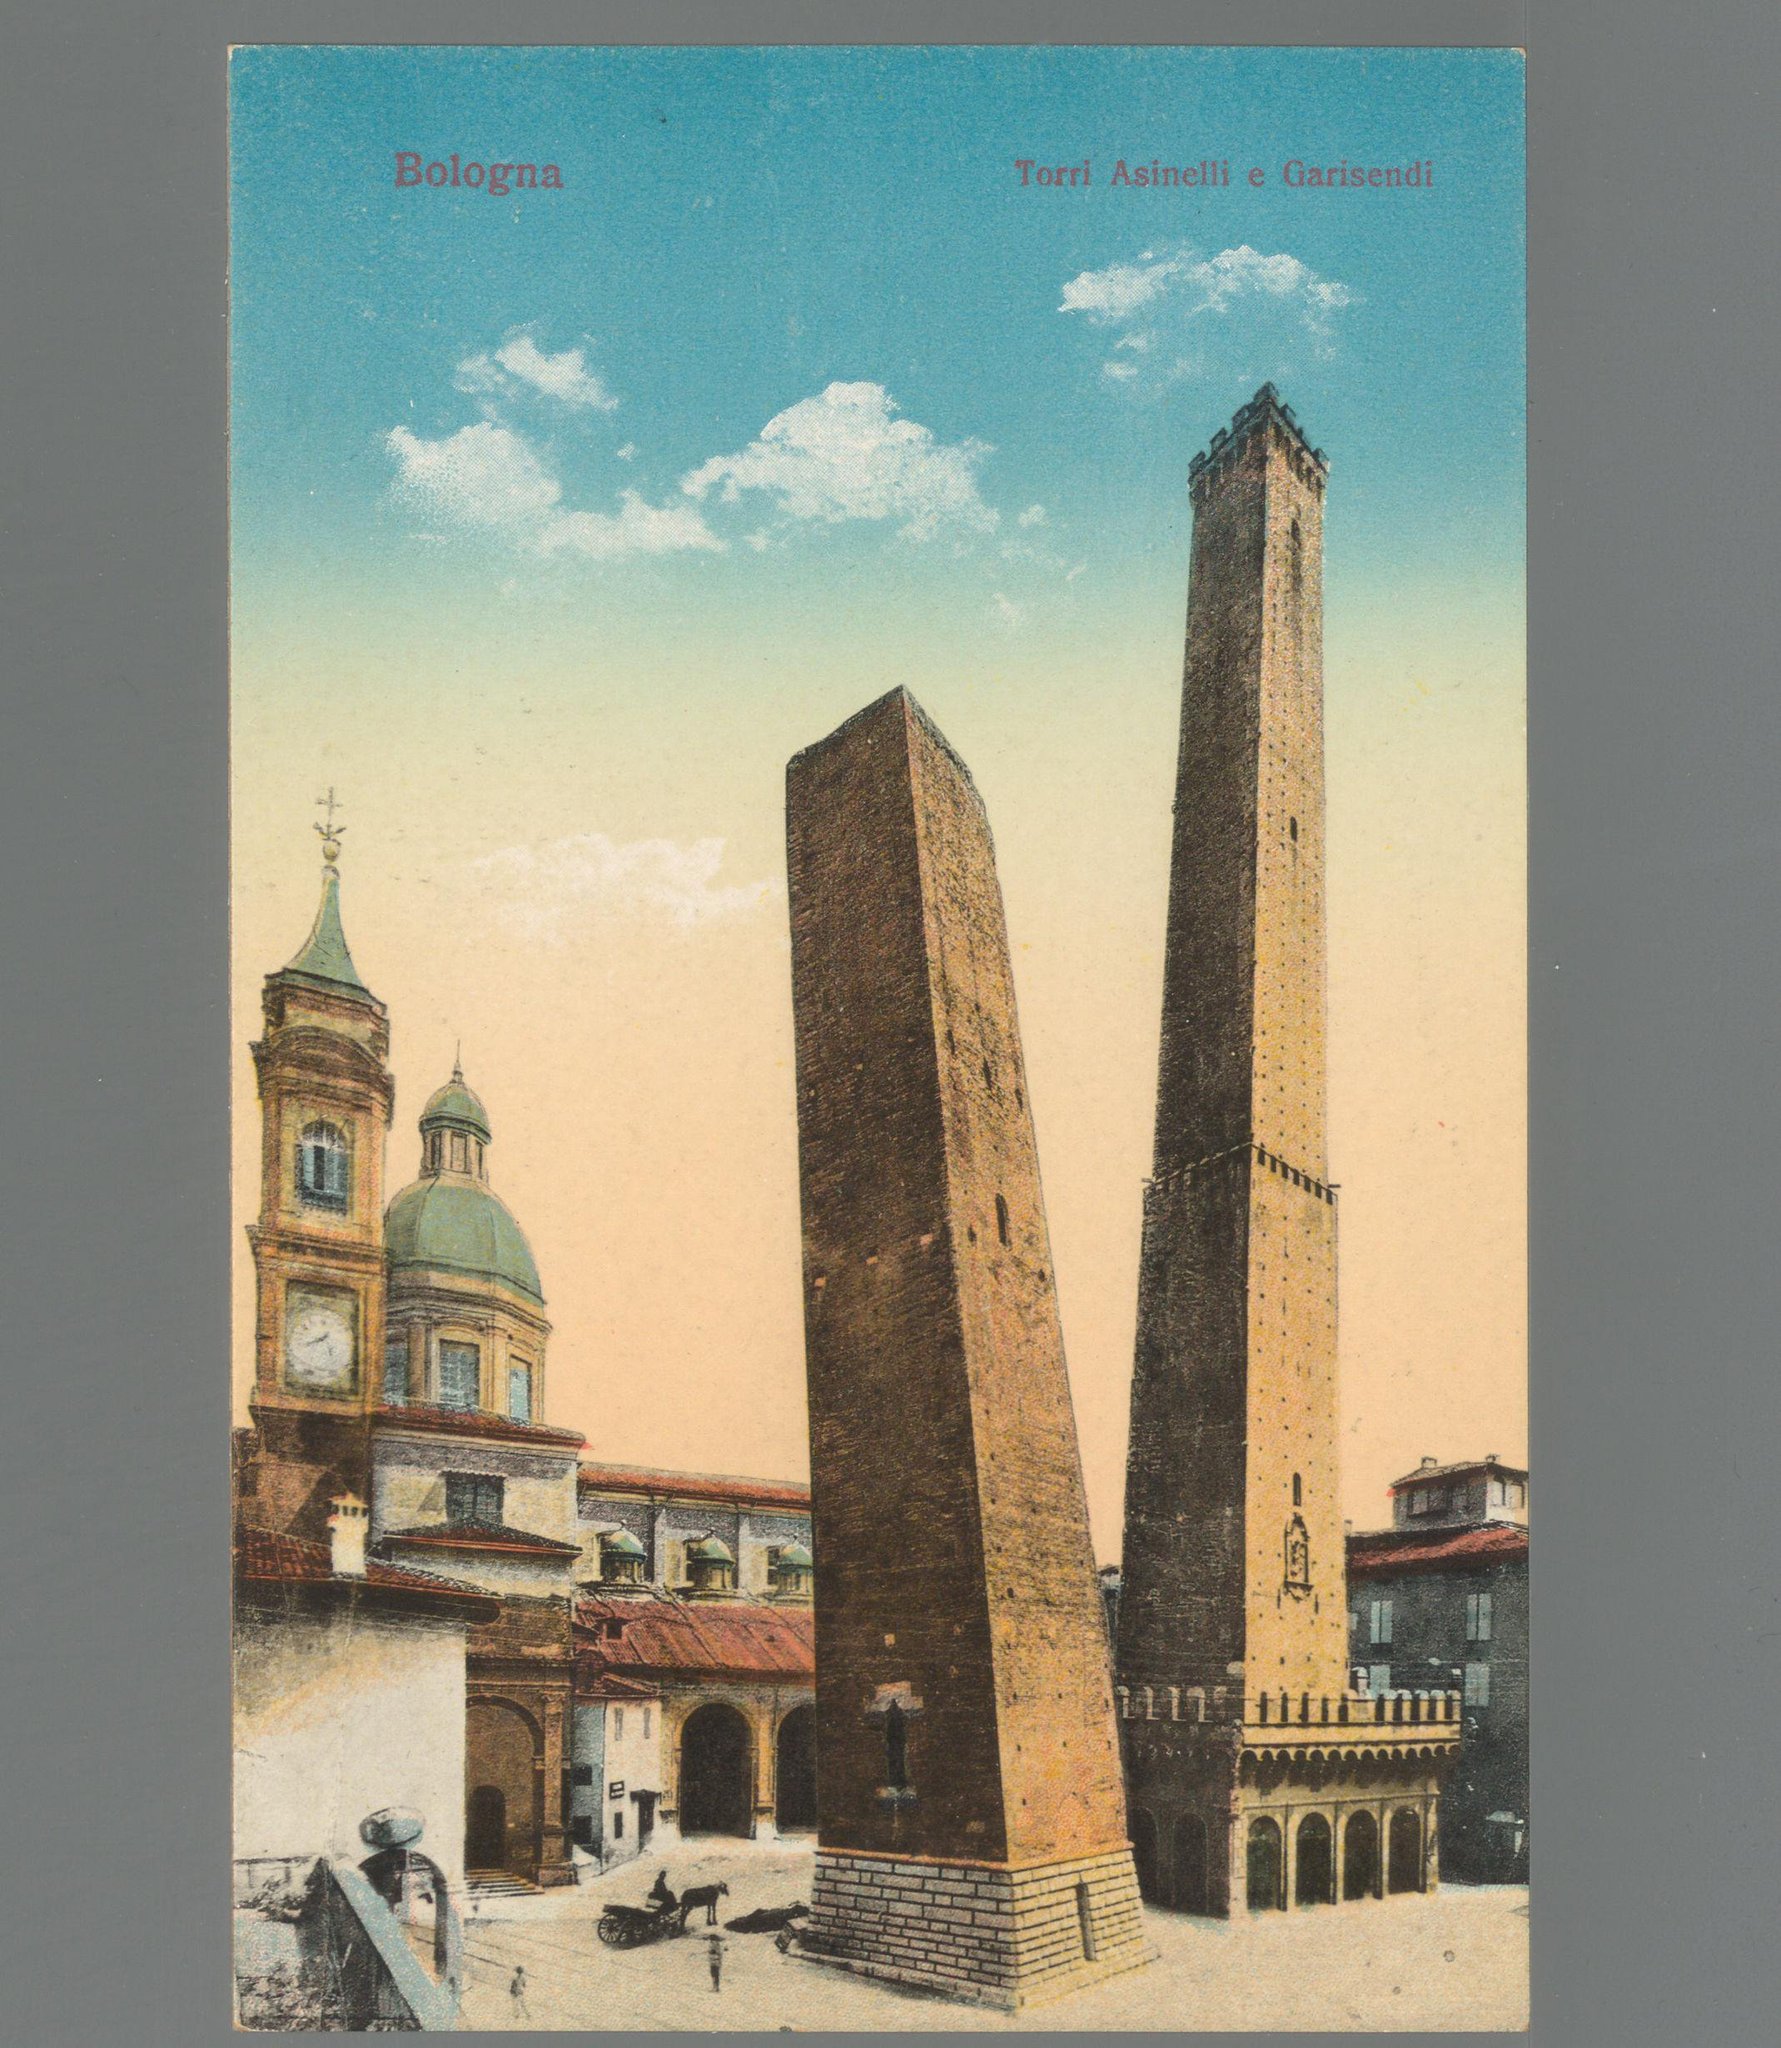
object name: ansichtkaart, prentbriefkaart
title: Bologna. Torri Asinelli e Garisendi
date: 1905-1930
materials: cardboard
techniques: photograph, lithograph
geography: zurich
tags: urban housing, tower, clock tower ~ monumental adornment (+ city(-scape) with figures, staffage)